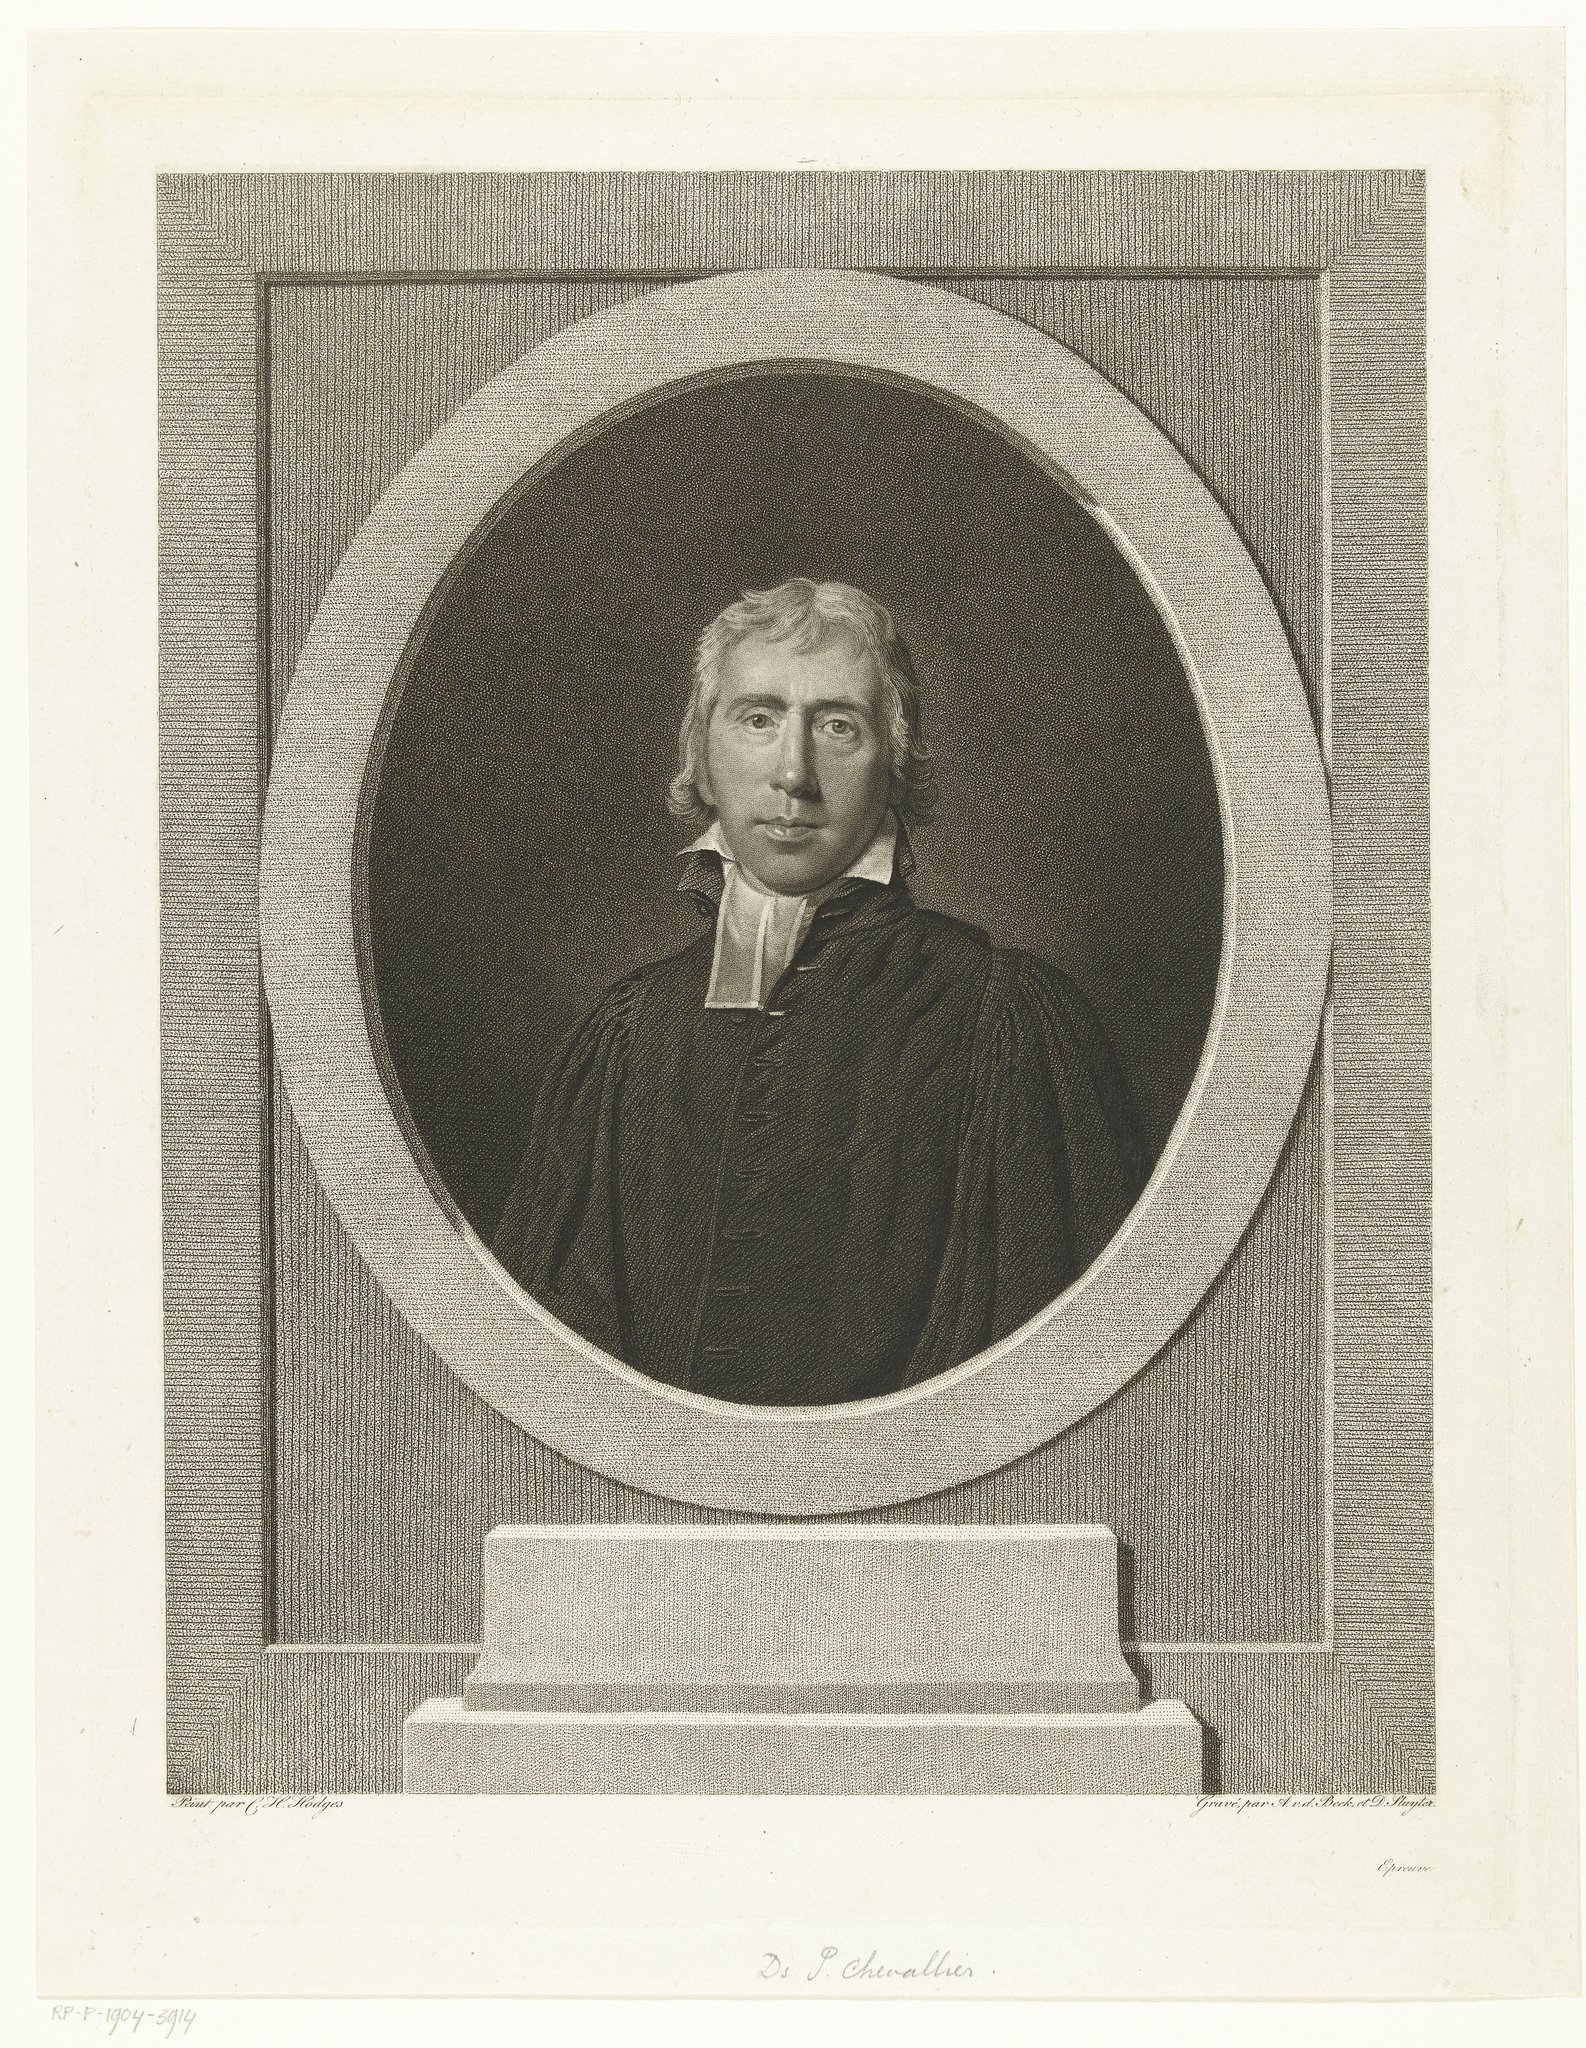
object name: print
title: Portret van Waals predikant Pierre Chevalier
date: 1793-1852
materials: paper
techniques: aquatint, etching, roulette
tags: functionaries and dignitaries (with name) ~ episcopal protestant churches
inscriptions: collector's mark: Lugt 2228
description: Prent naar ontwerp van C.H. Hodges. Vergelijk tweede staat prent in collectie Stadsarchief Amsterdam met opschrift.